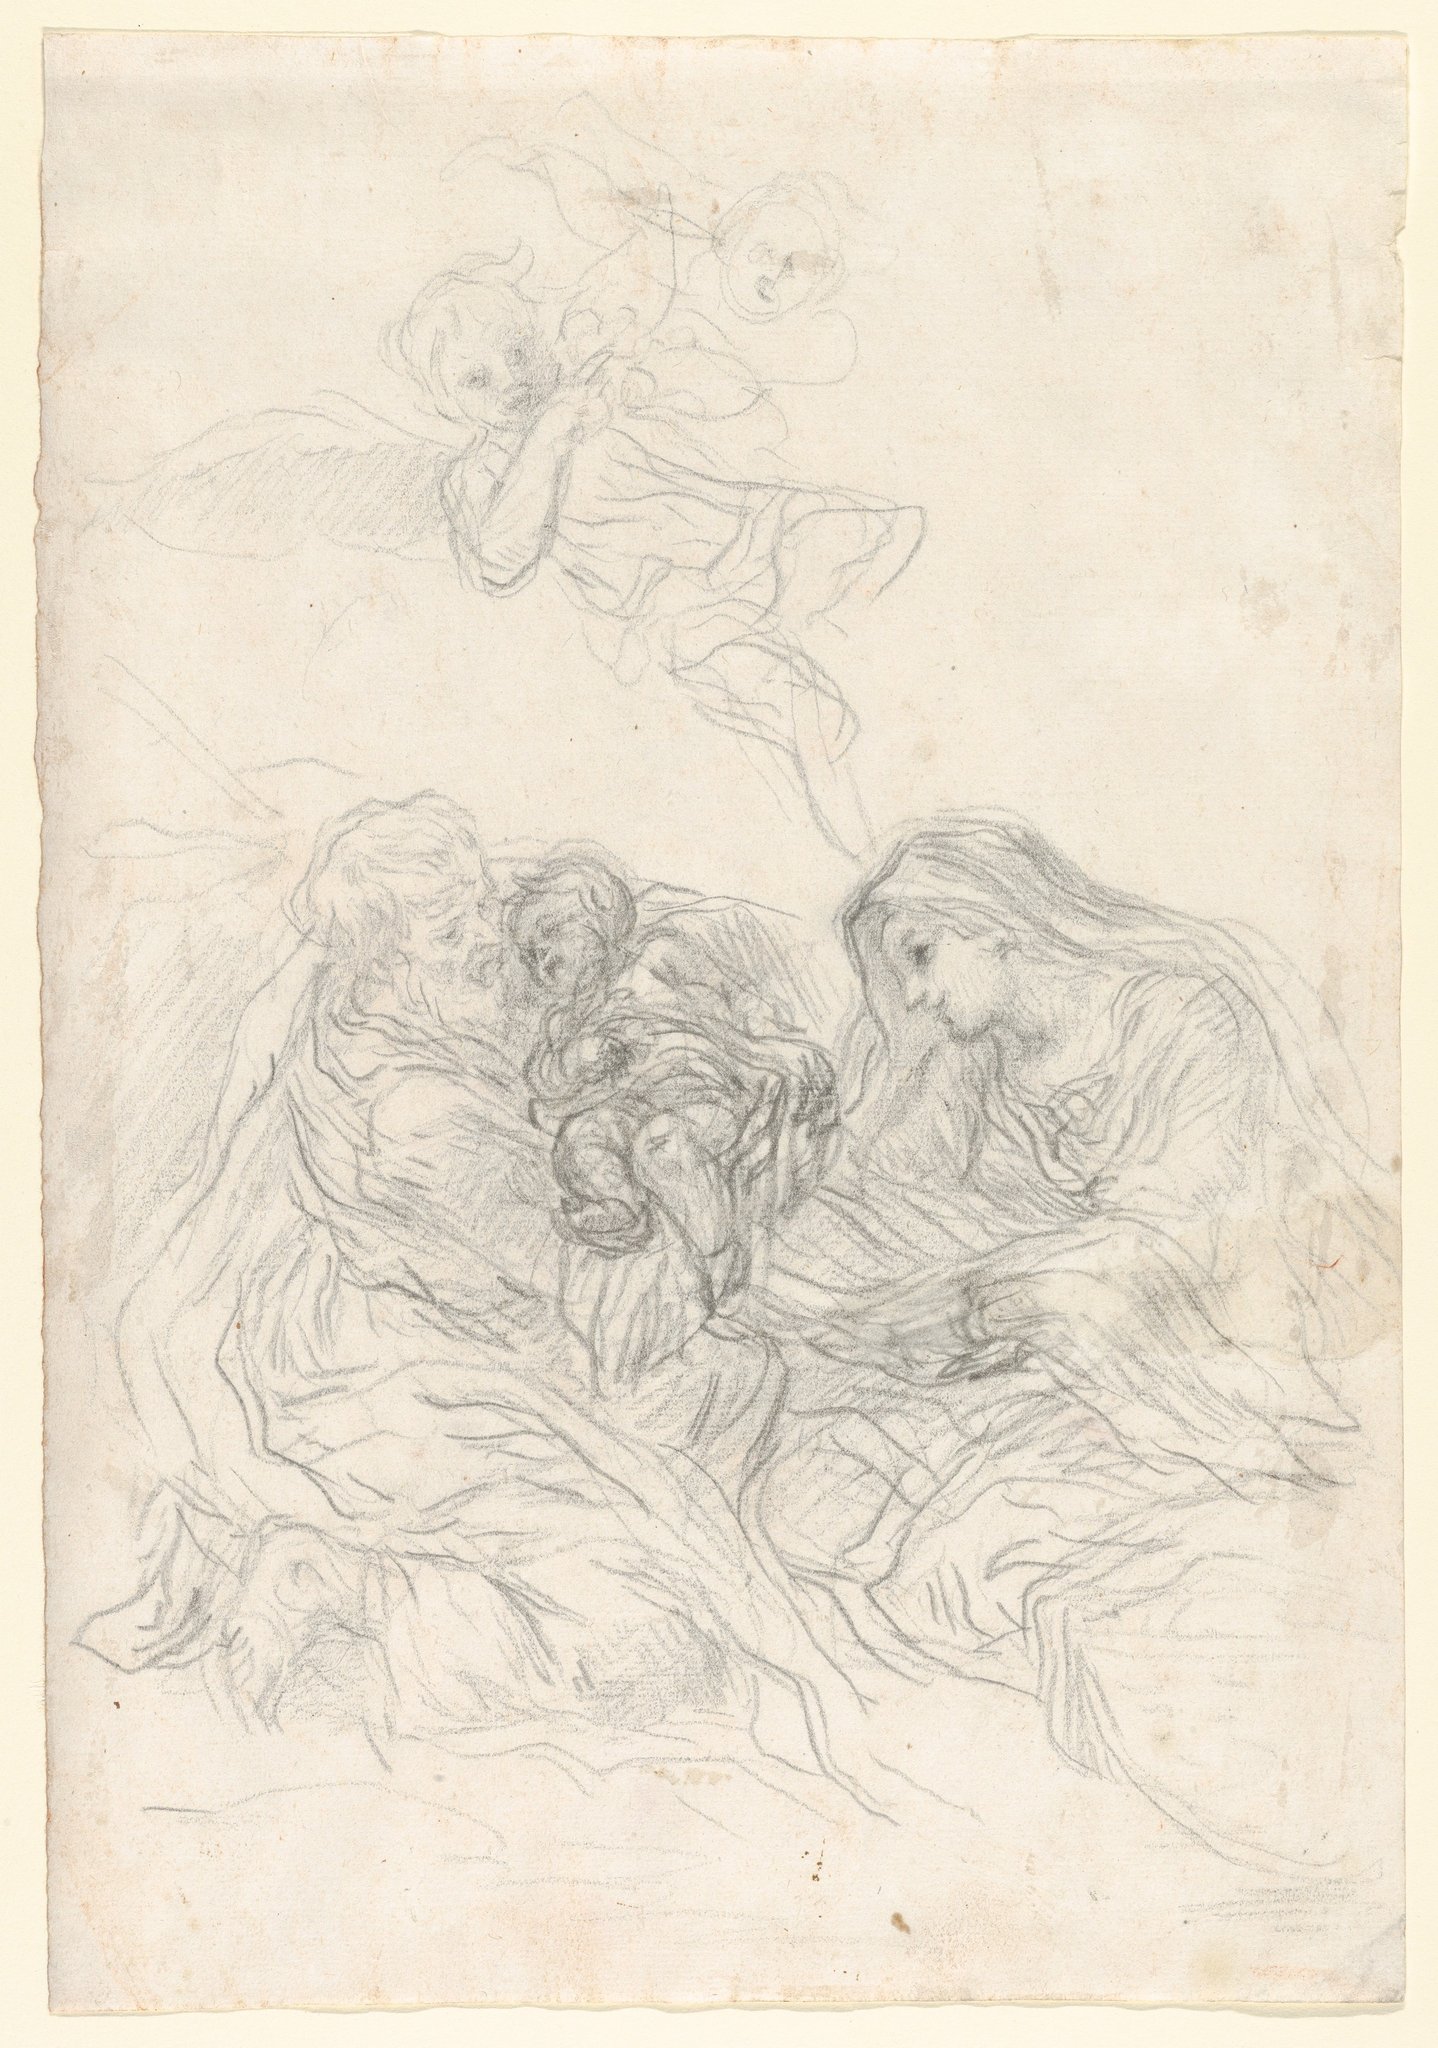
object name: drawing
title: Holy Family with Two Flying Angels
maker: baldassarre franceschini (il volterrano)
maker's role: artist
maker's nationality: italian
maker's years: 1611-1690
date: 1640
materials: chalk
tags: angels,holy family